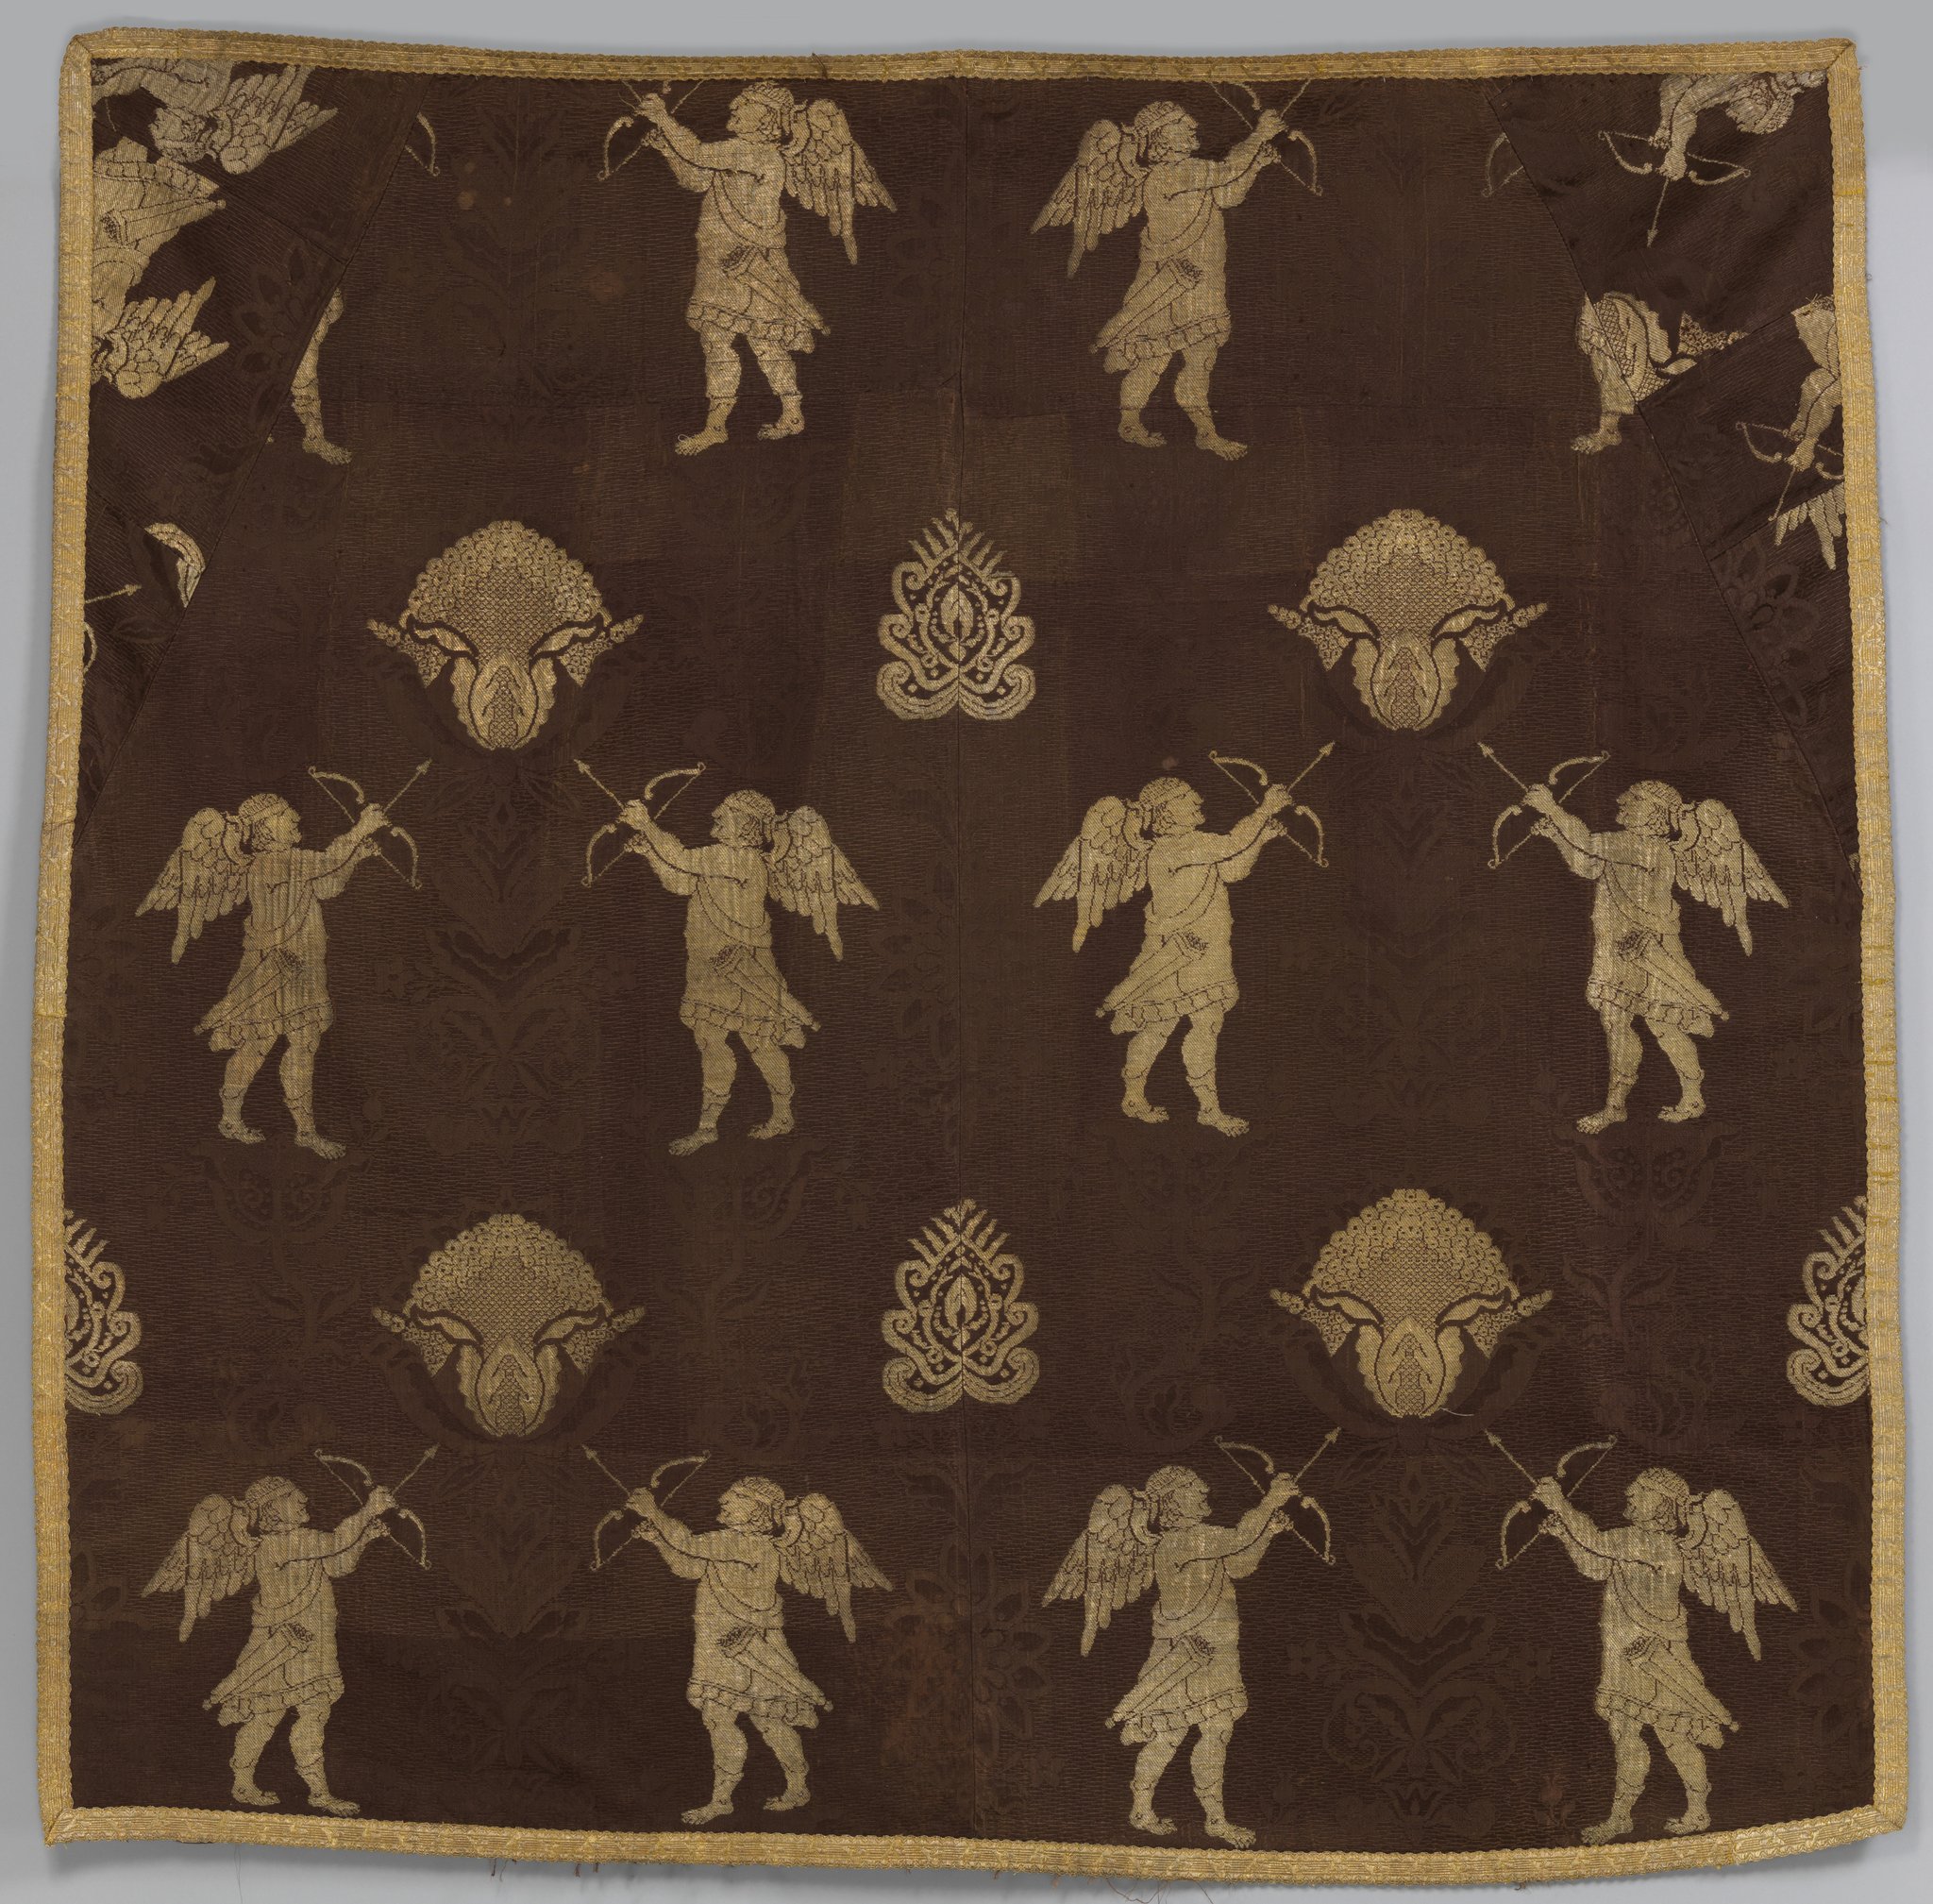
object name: piece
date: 1710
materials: metal thread, silk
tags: cupid